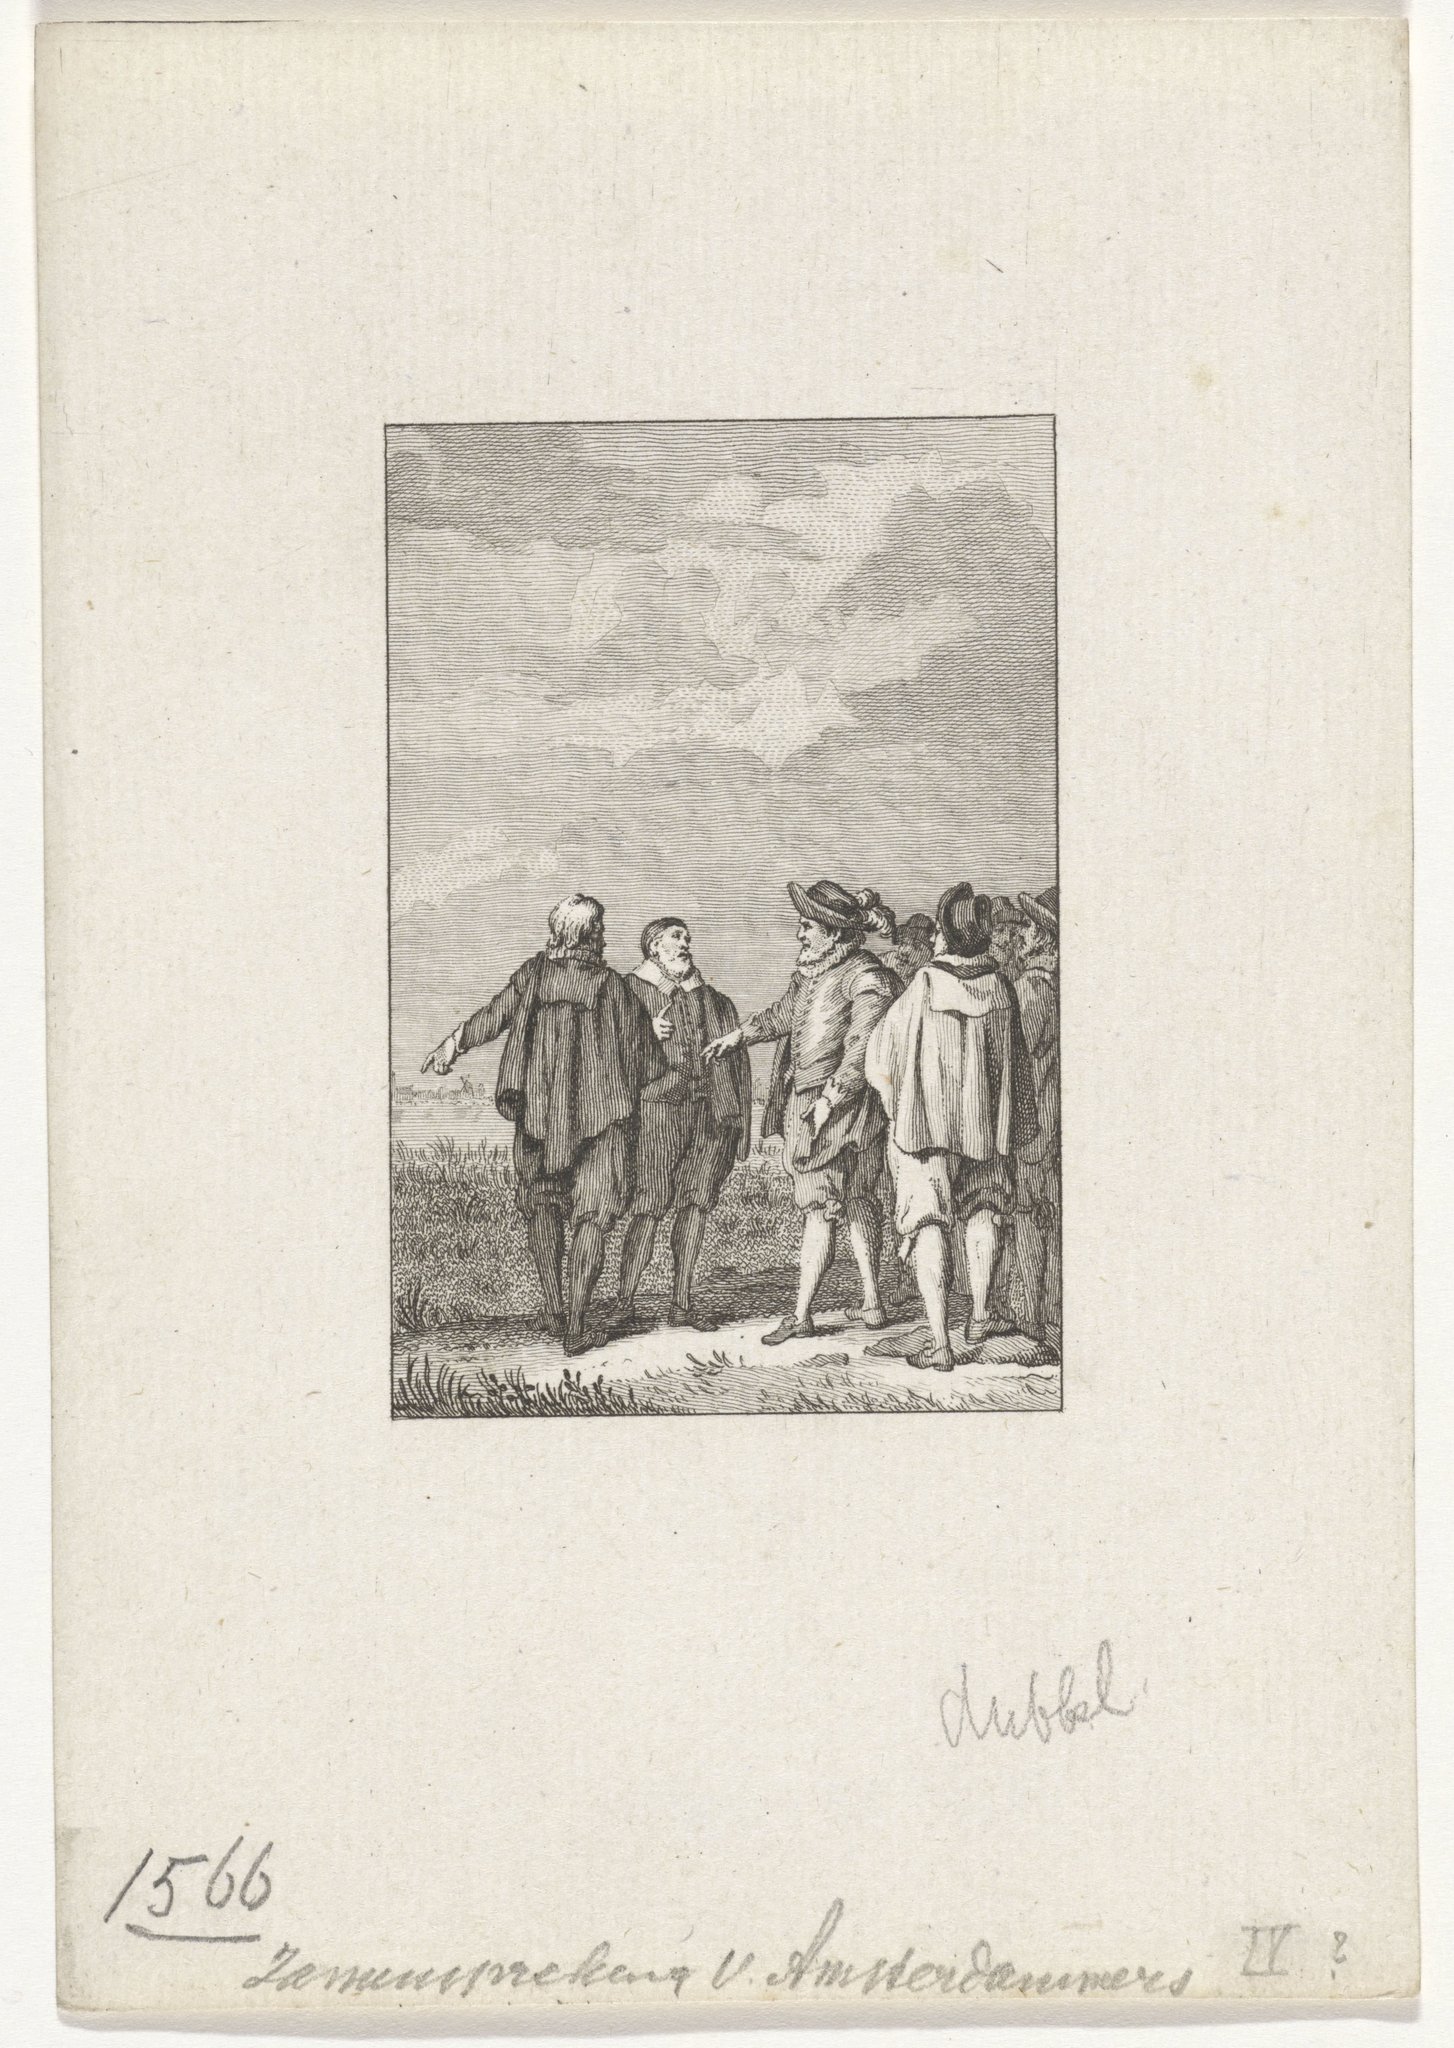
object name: history print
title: Overleg tussen zes voorname Amsterdammers, 1566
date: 1783-1795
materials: paper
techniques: etching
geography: amsterdam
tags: debate, discussion (~ meeting), amsterdam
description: Illustratie voor: J. Fokke. Geschiedenissen der Vereenigde Nederlanden voor de vaderlandsche jeugd. Amsterdam: Johannes Allart, 1783-1795, 25 delen. deel IV pl. III.